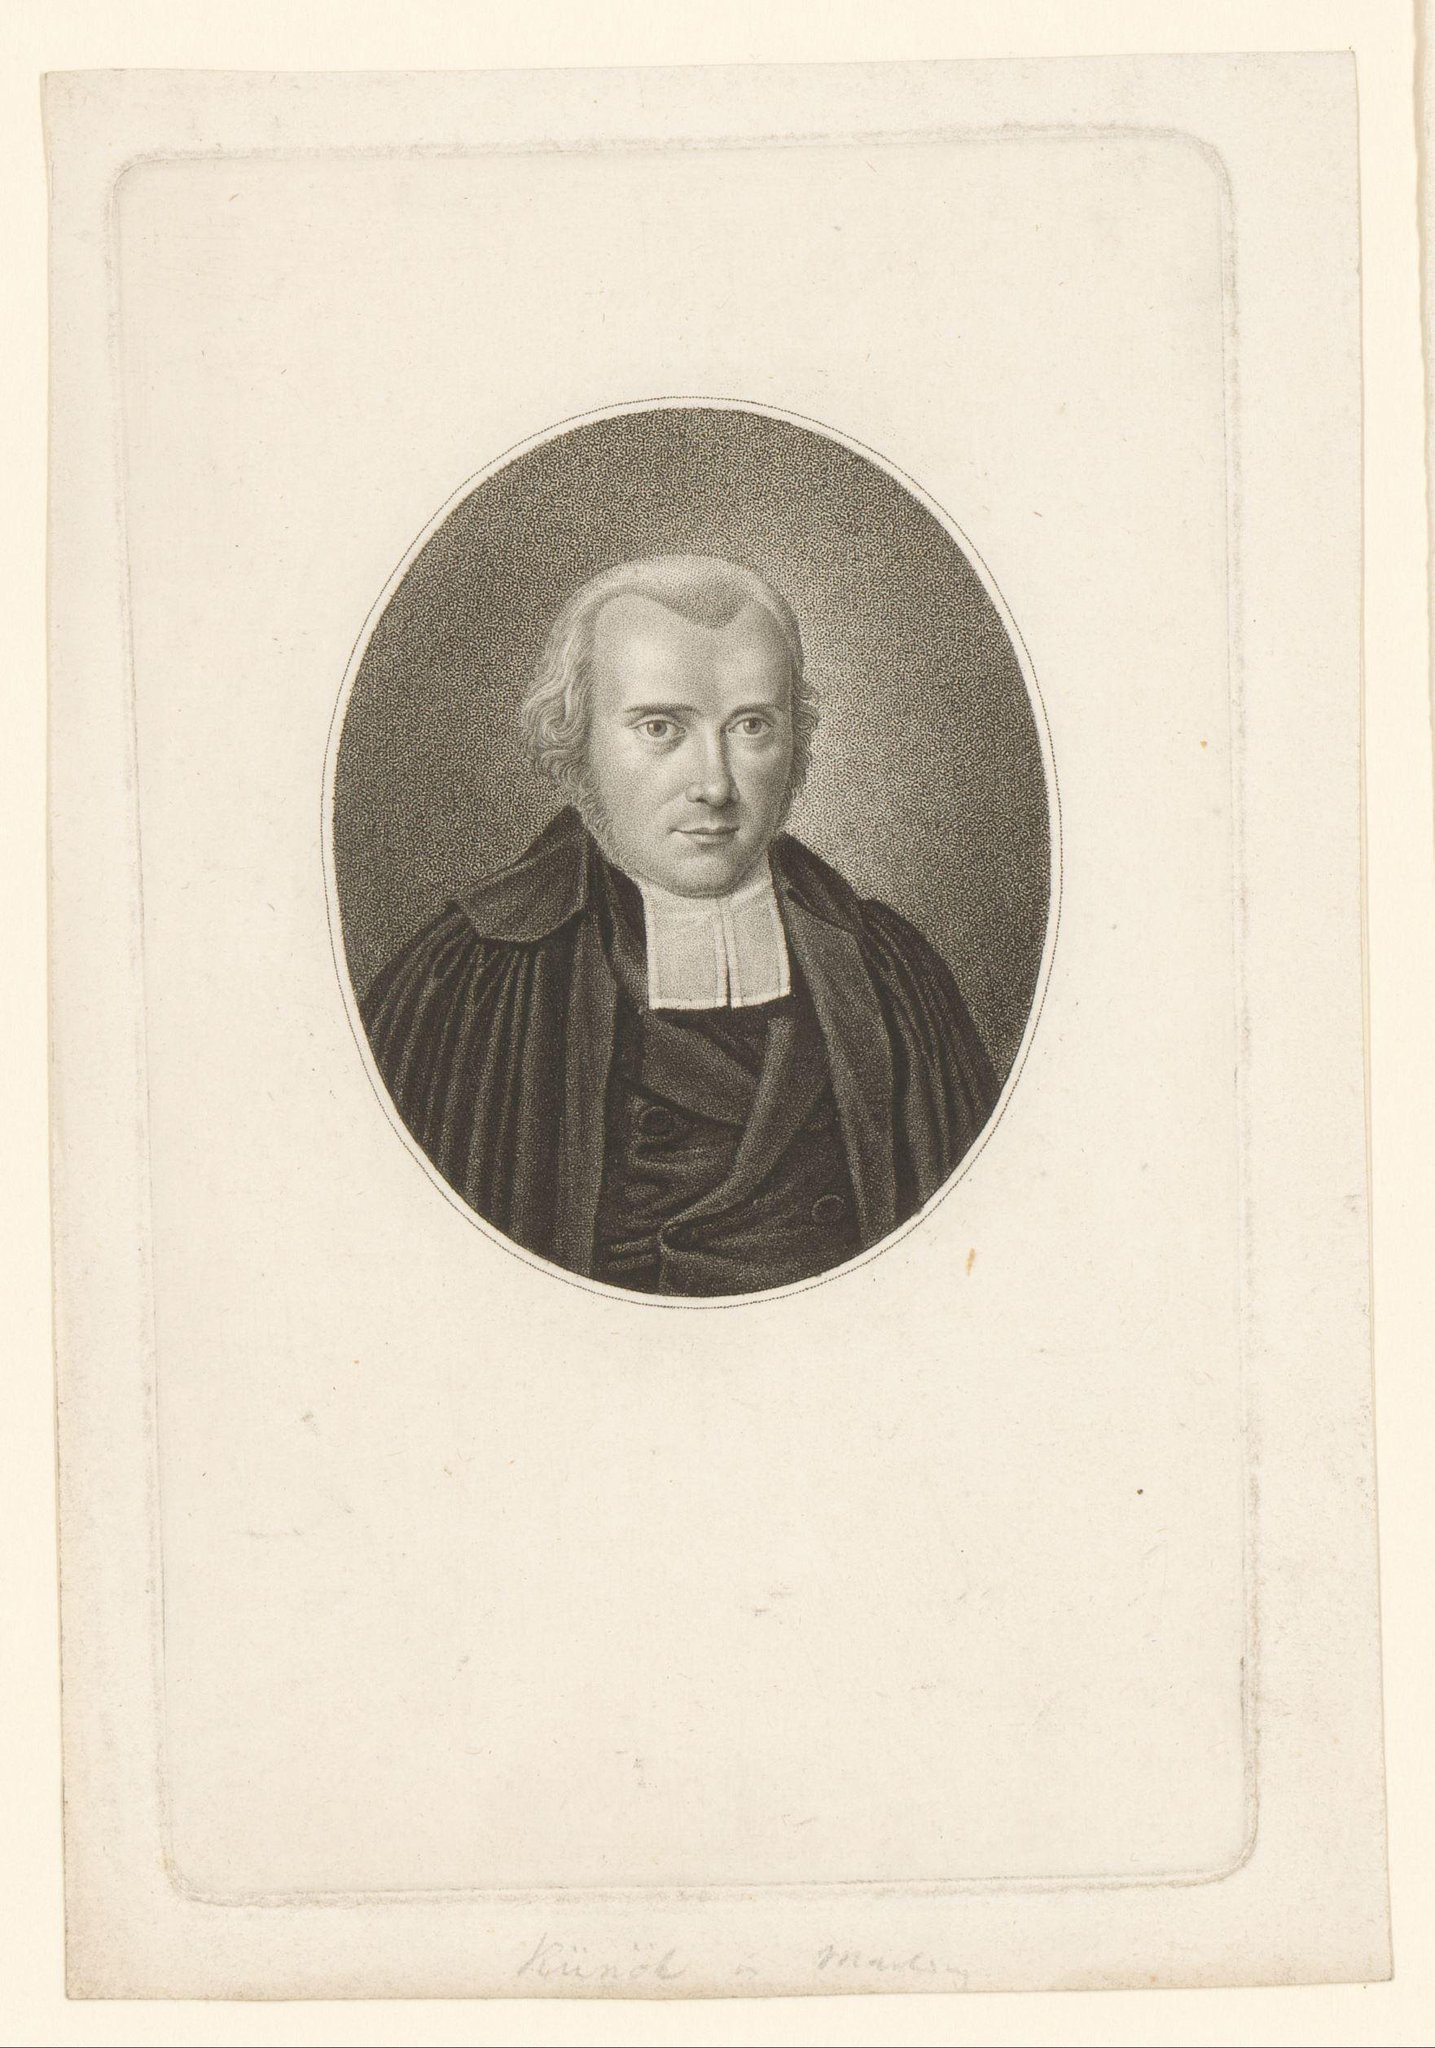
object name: print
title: Portret van Christian Gottlieb Kühnöl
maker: friedrich rossmässler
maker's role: print maker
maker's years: 1775-1858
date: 1785-1858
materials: paper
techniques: engraving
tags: theologian, historical persons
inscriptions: collector's mark: Lugt 2228